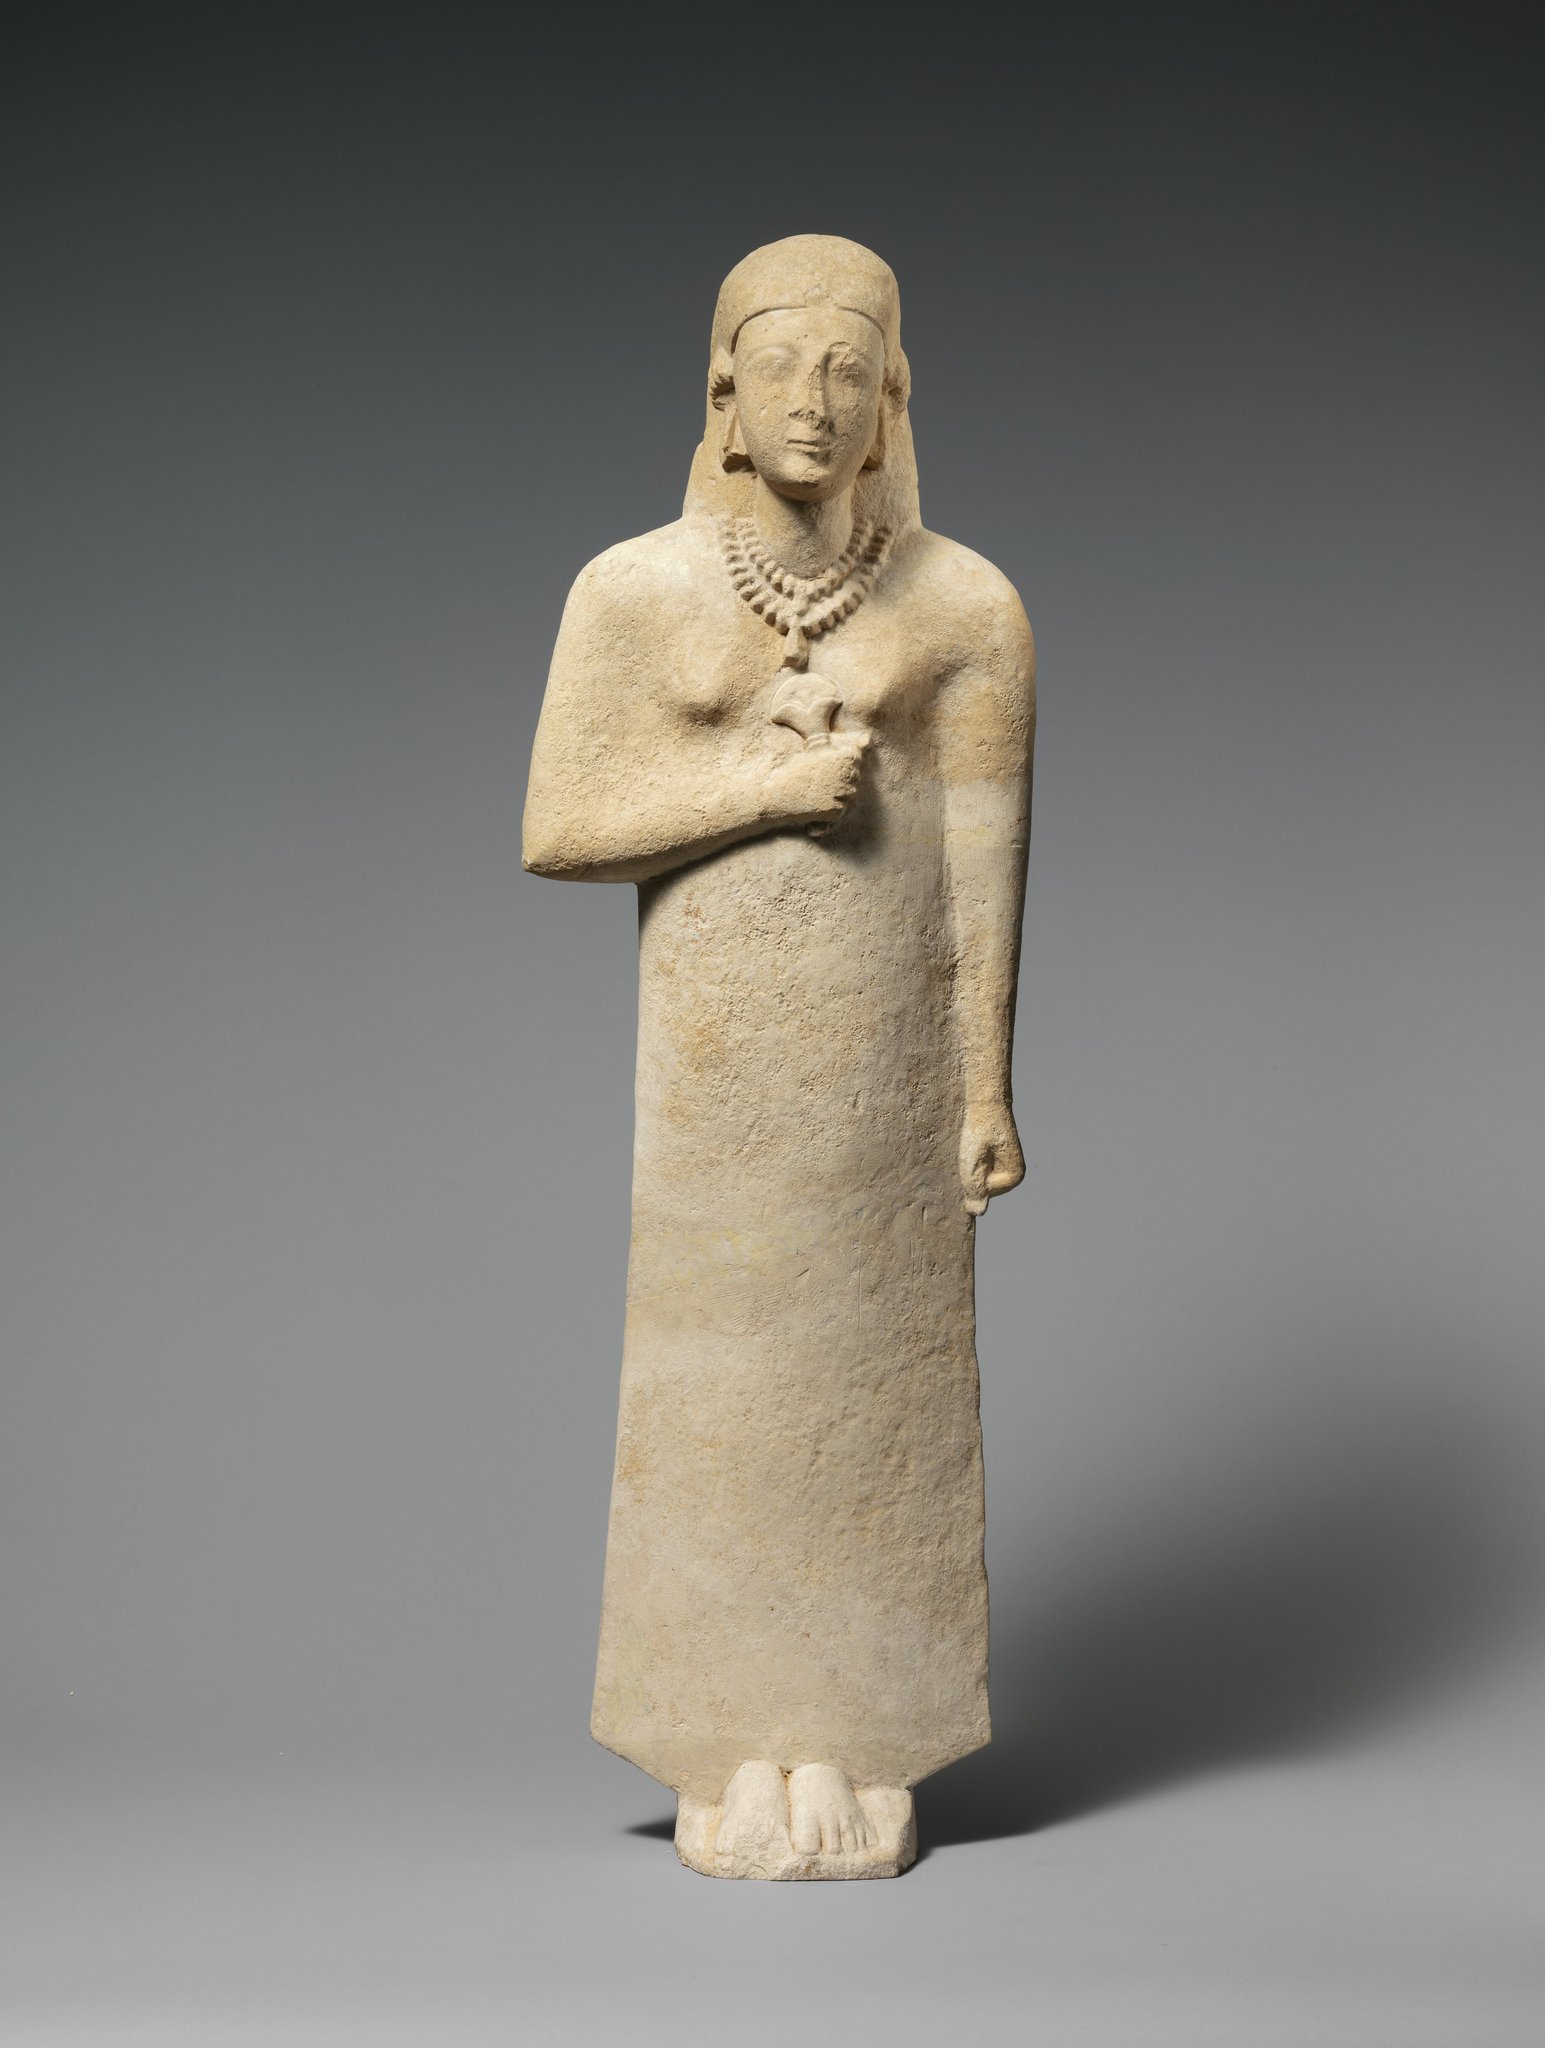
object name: statue of a woman in assyrian dress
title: Limestone statue of a woman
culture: cypriot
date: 600-568 BCE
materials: limestone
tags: earrings,necklaces,women